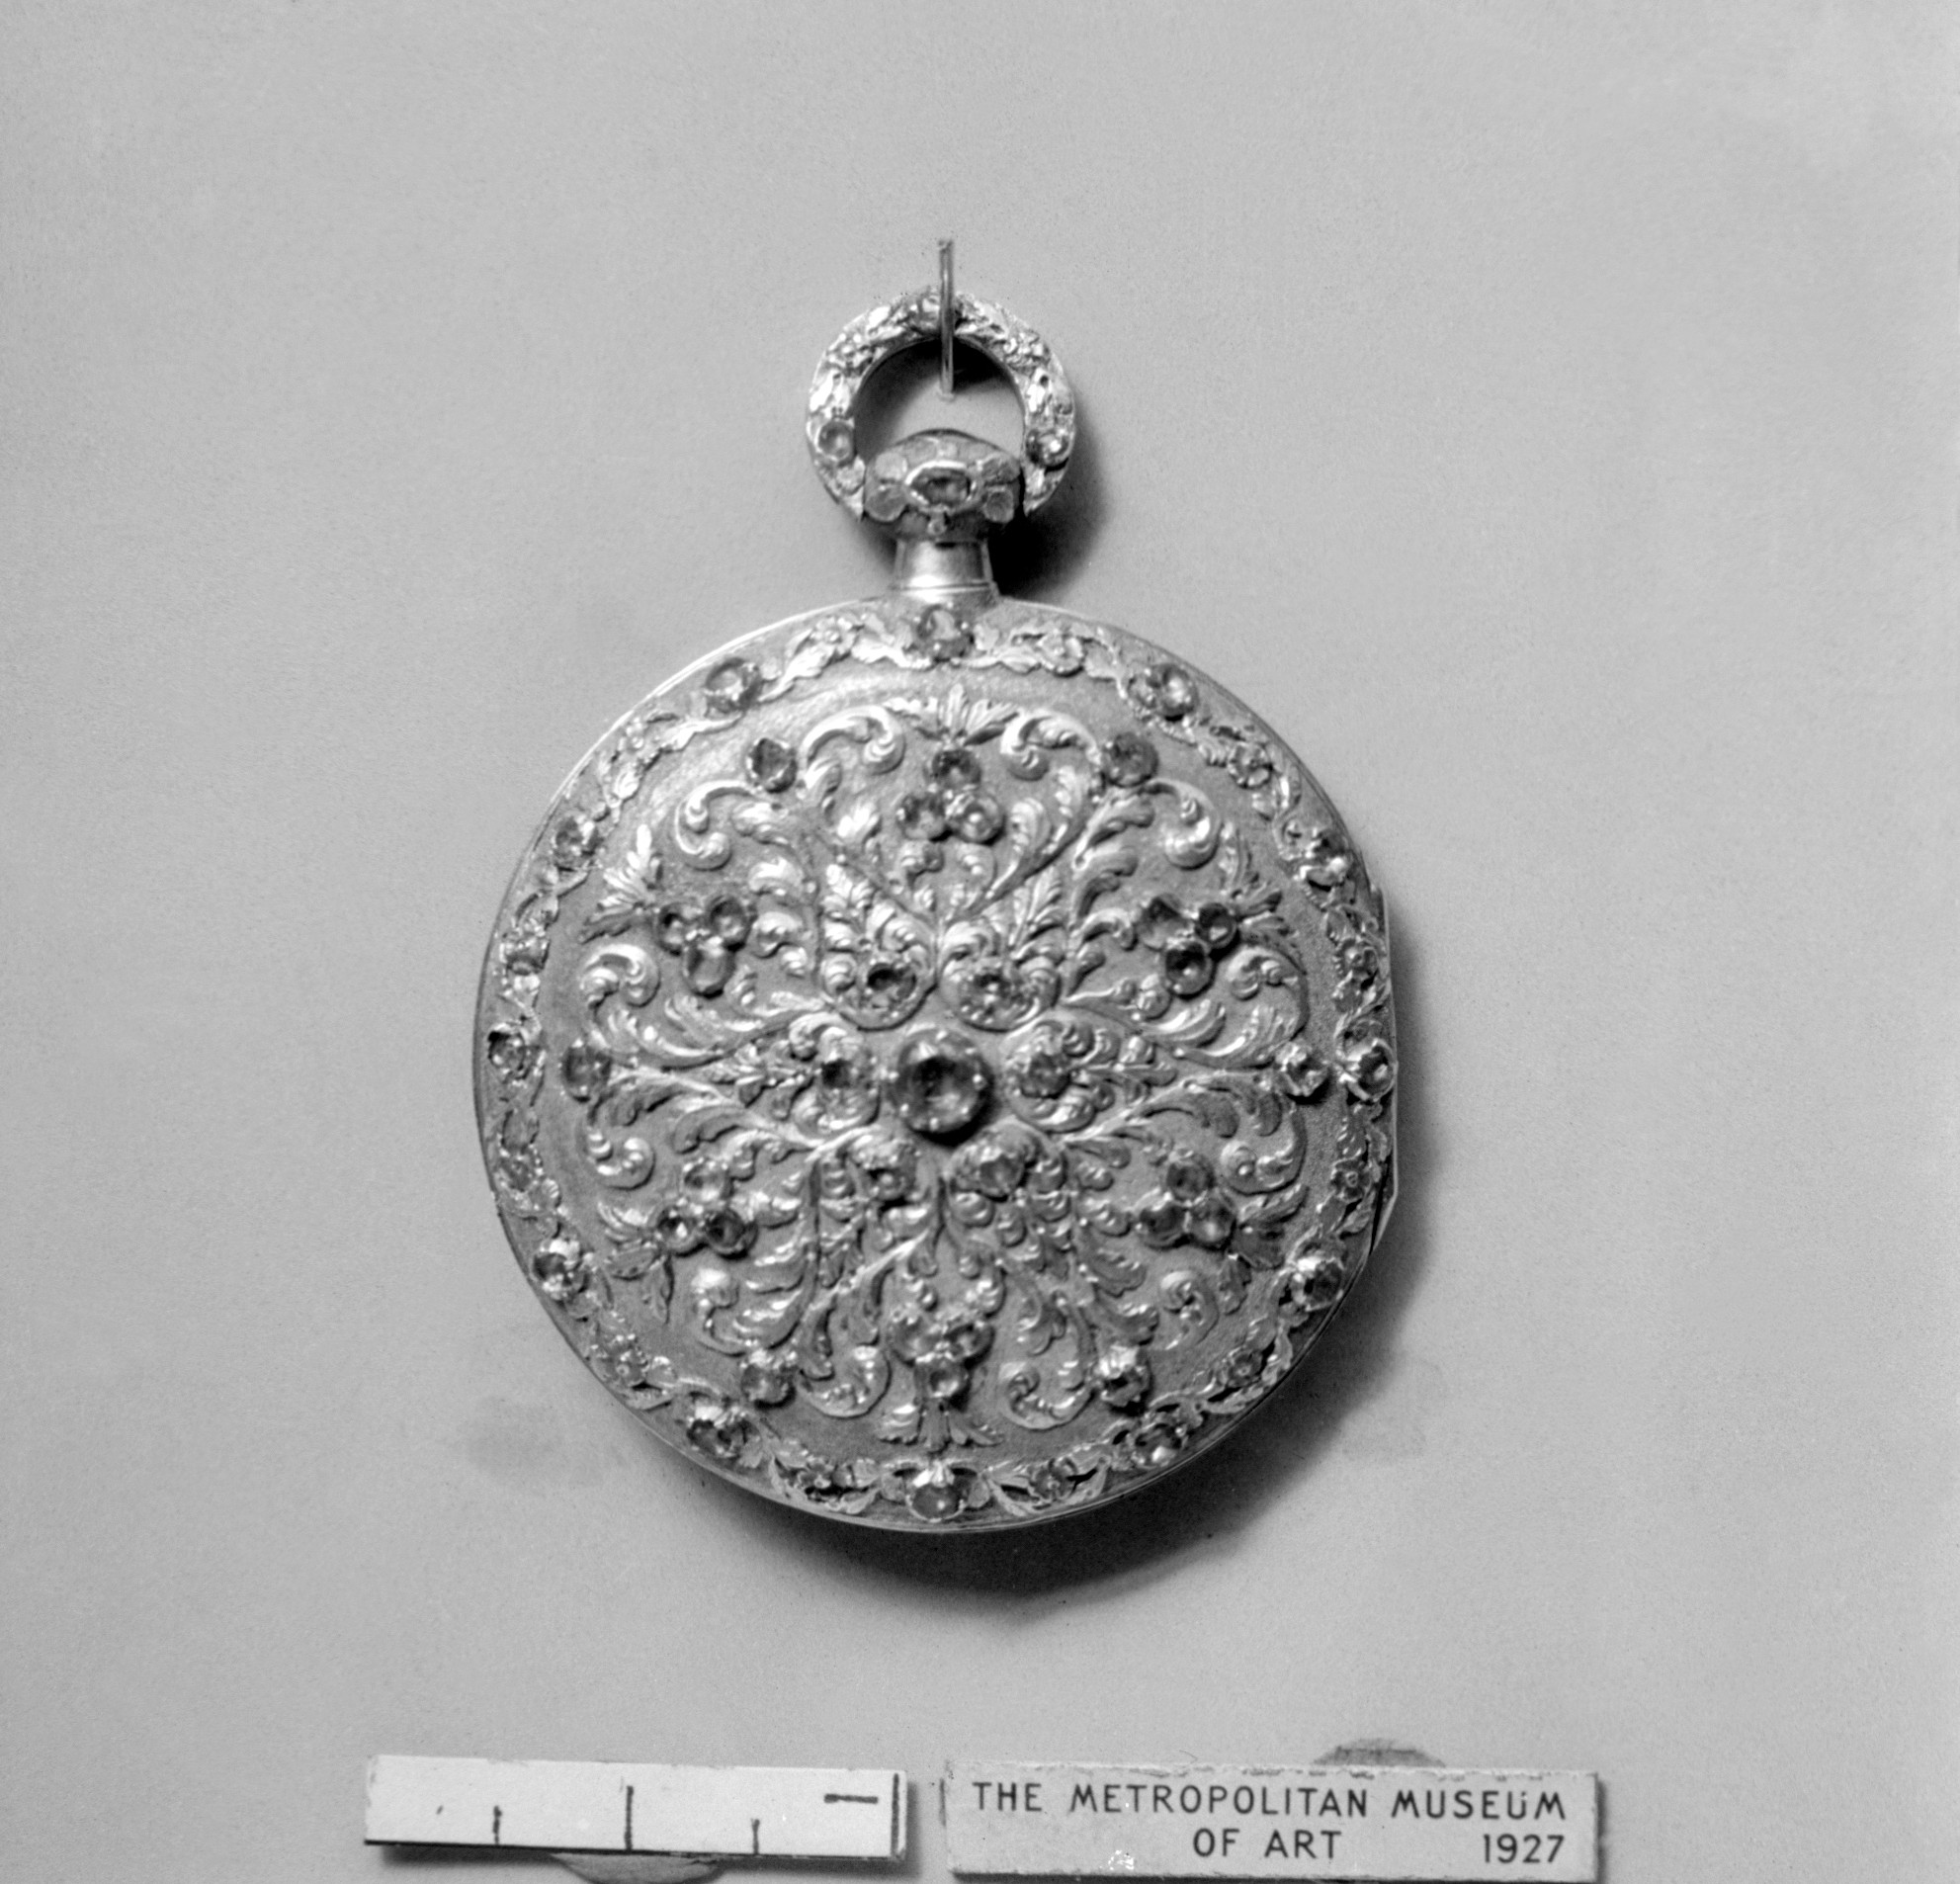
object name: watch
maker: firm of moulinié, bautte & moynier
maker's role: maker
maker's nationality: swiss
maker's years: 1808-1821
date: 1809-1821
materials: garnet, gold, gemstone, silver